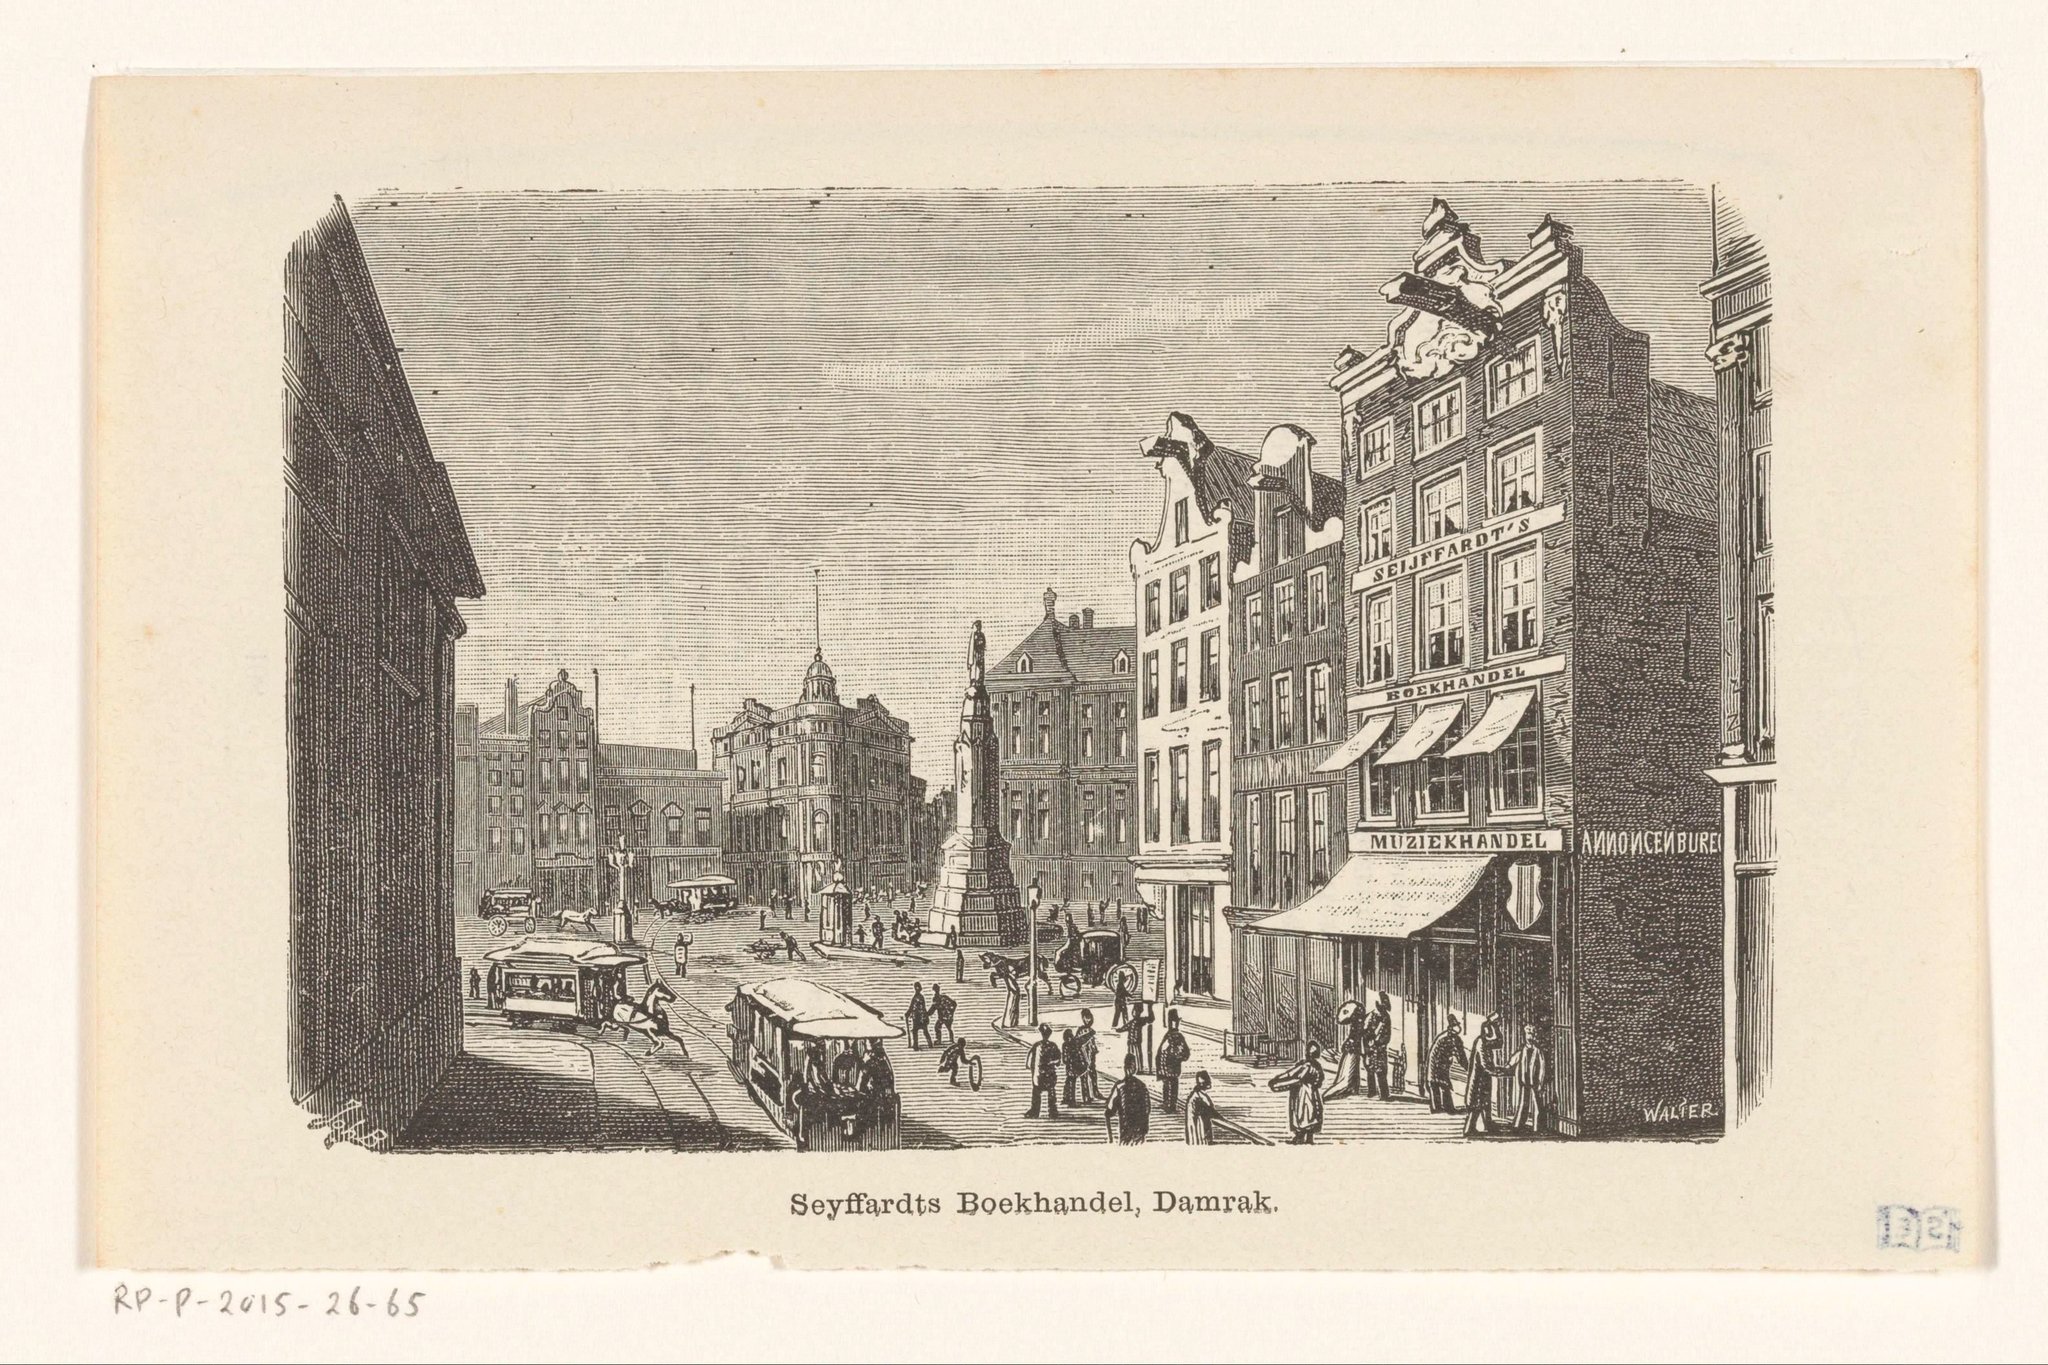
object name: book illustration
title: Seyffardt's Boekhandel op het Damrak te Amsterdam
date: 1892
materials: paper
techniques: letterpress printing, engraving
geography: amsterdam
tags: city-view in general; 'veduta' (+ city(-scape) with figures, staffage), book-shop, bookseller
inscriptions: collector's mark: Lugt 4780, collector's mark: Lugt 2228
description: Gezicht op het Damrak in zuidelijke richting, naar de Dam gezien. Op nr. 99 Seyffardt's boek- en muziekhandel. Op de achtergrond Naatje op de Dam.